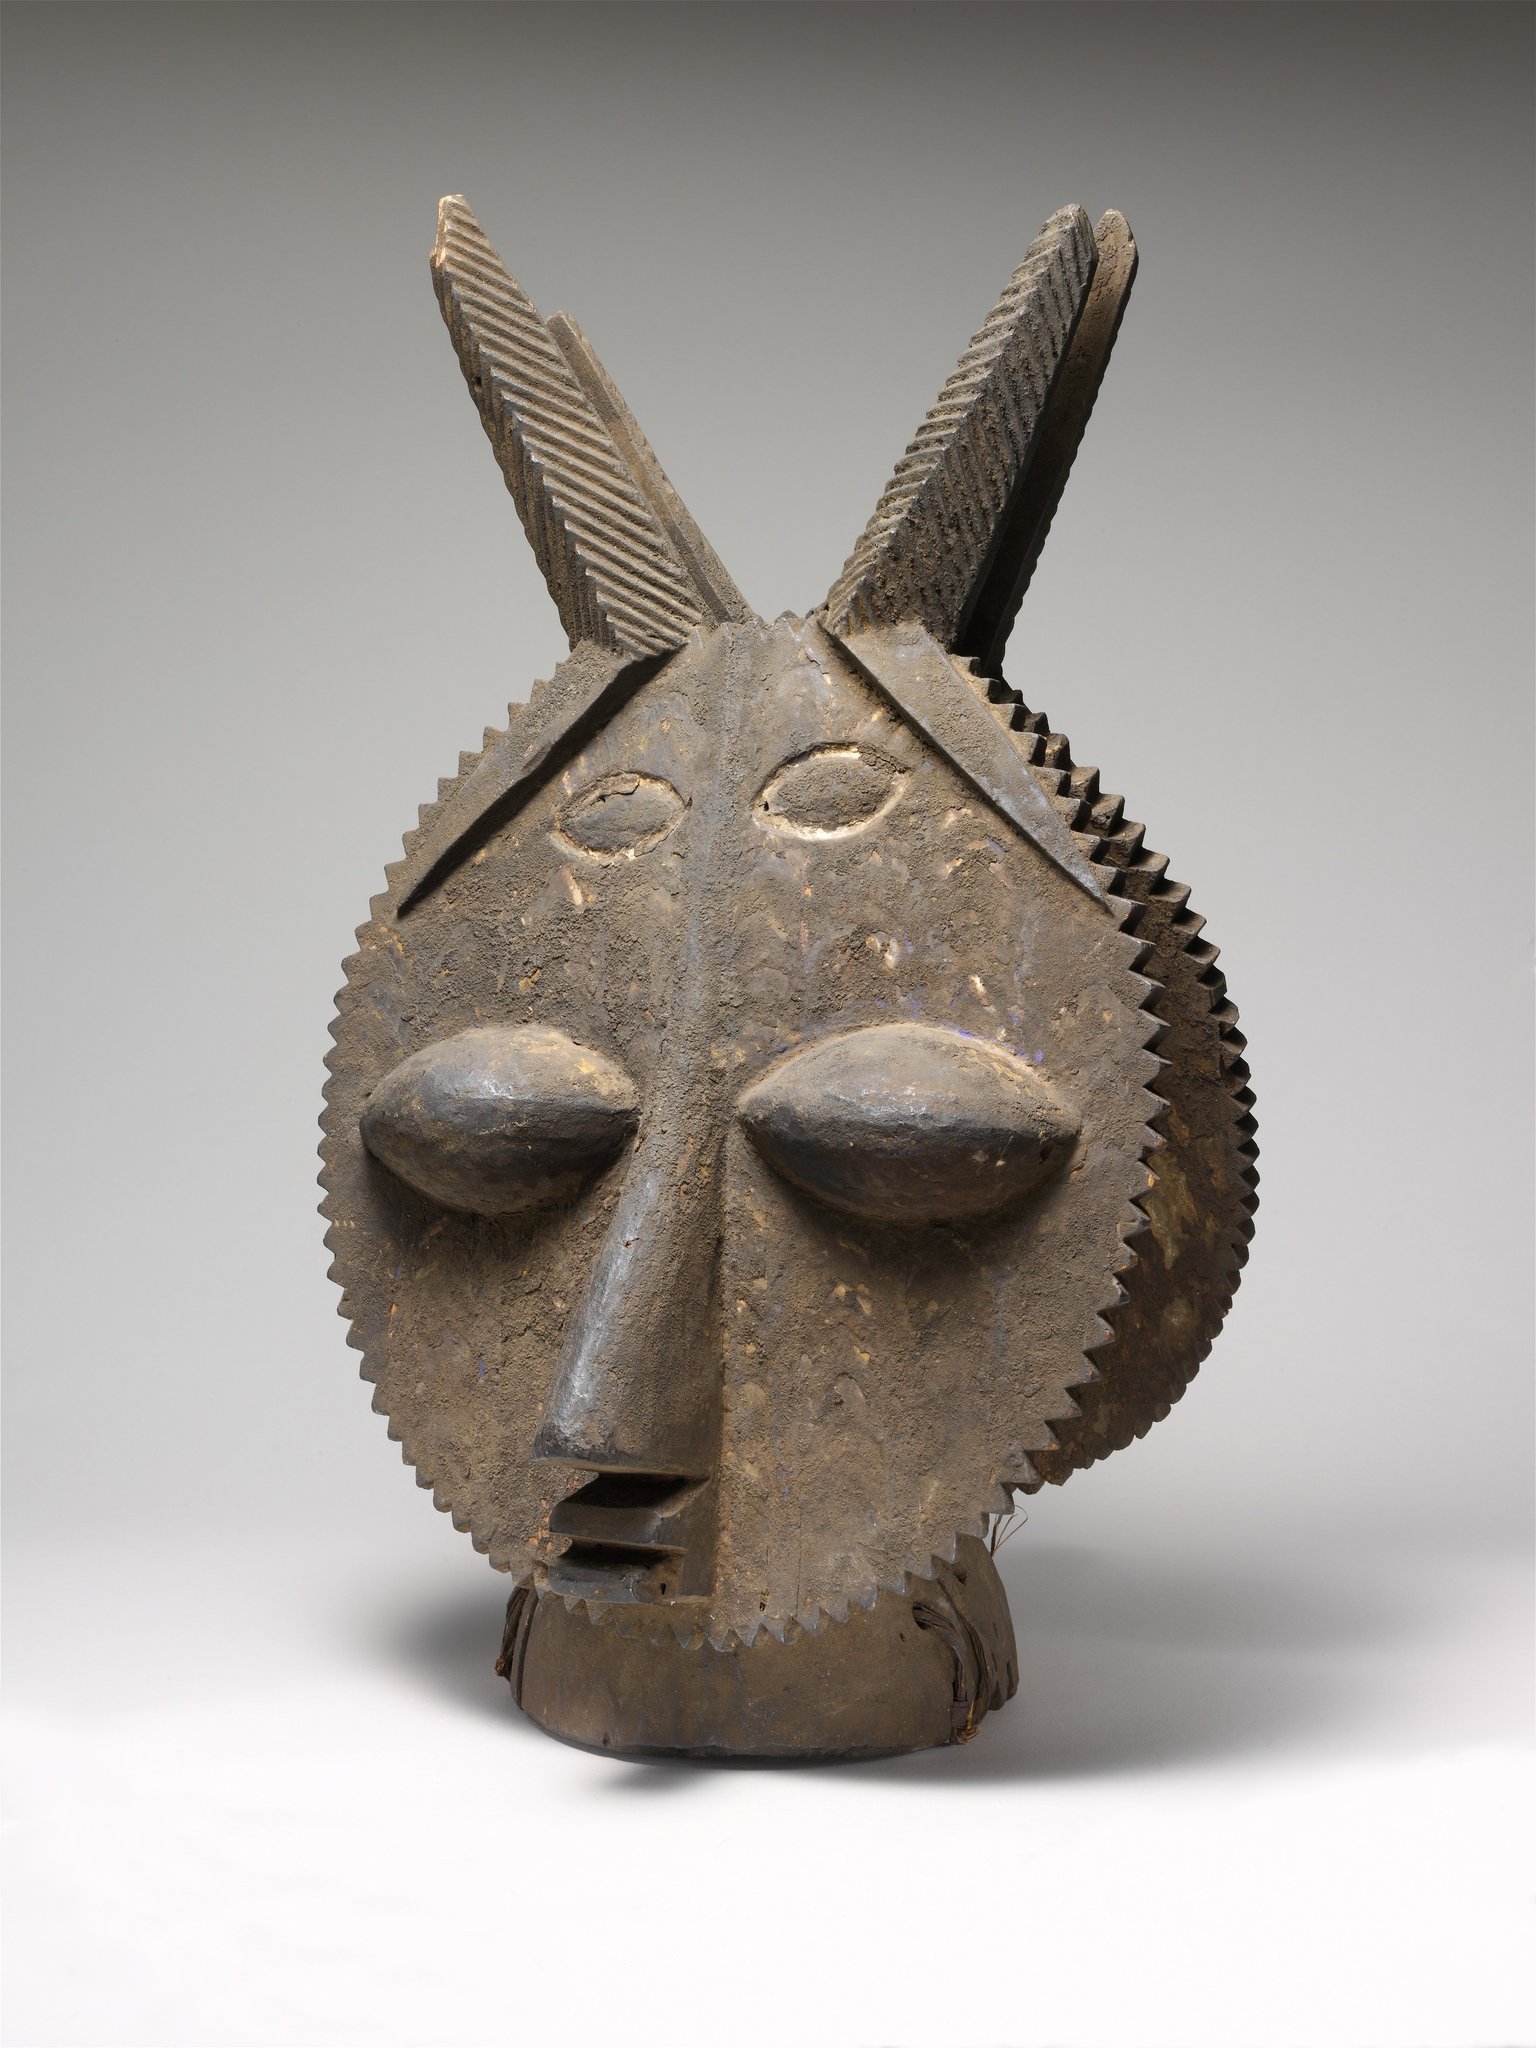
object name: headdress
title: Double-faced water spirit crest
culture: yoruba peoples, ijebu group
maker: ijebu-yoruba artist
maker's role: artist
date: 1901-1933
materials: pigment, wood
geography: nigeria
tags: heads